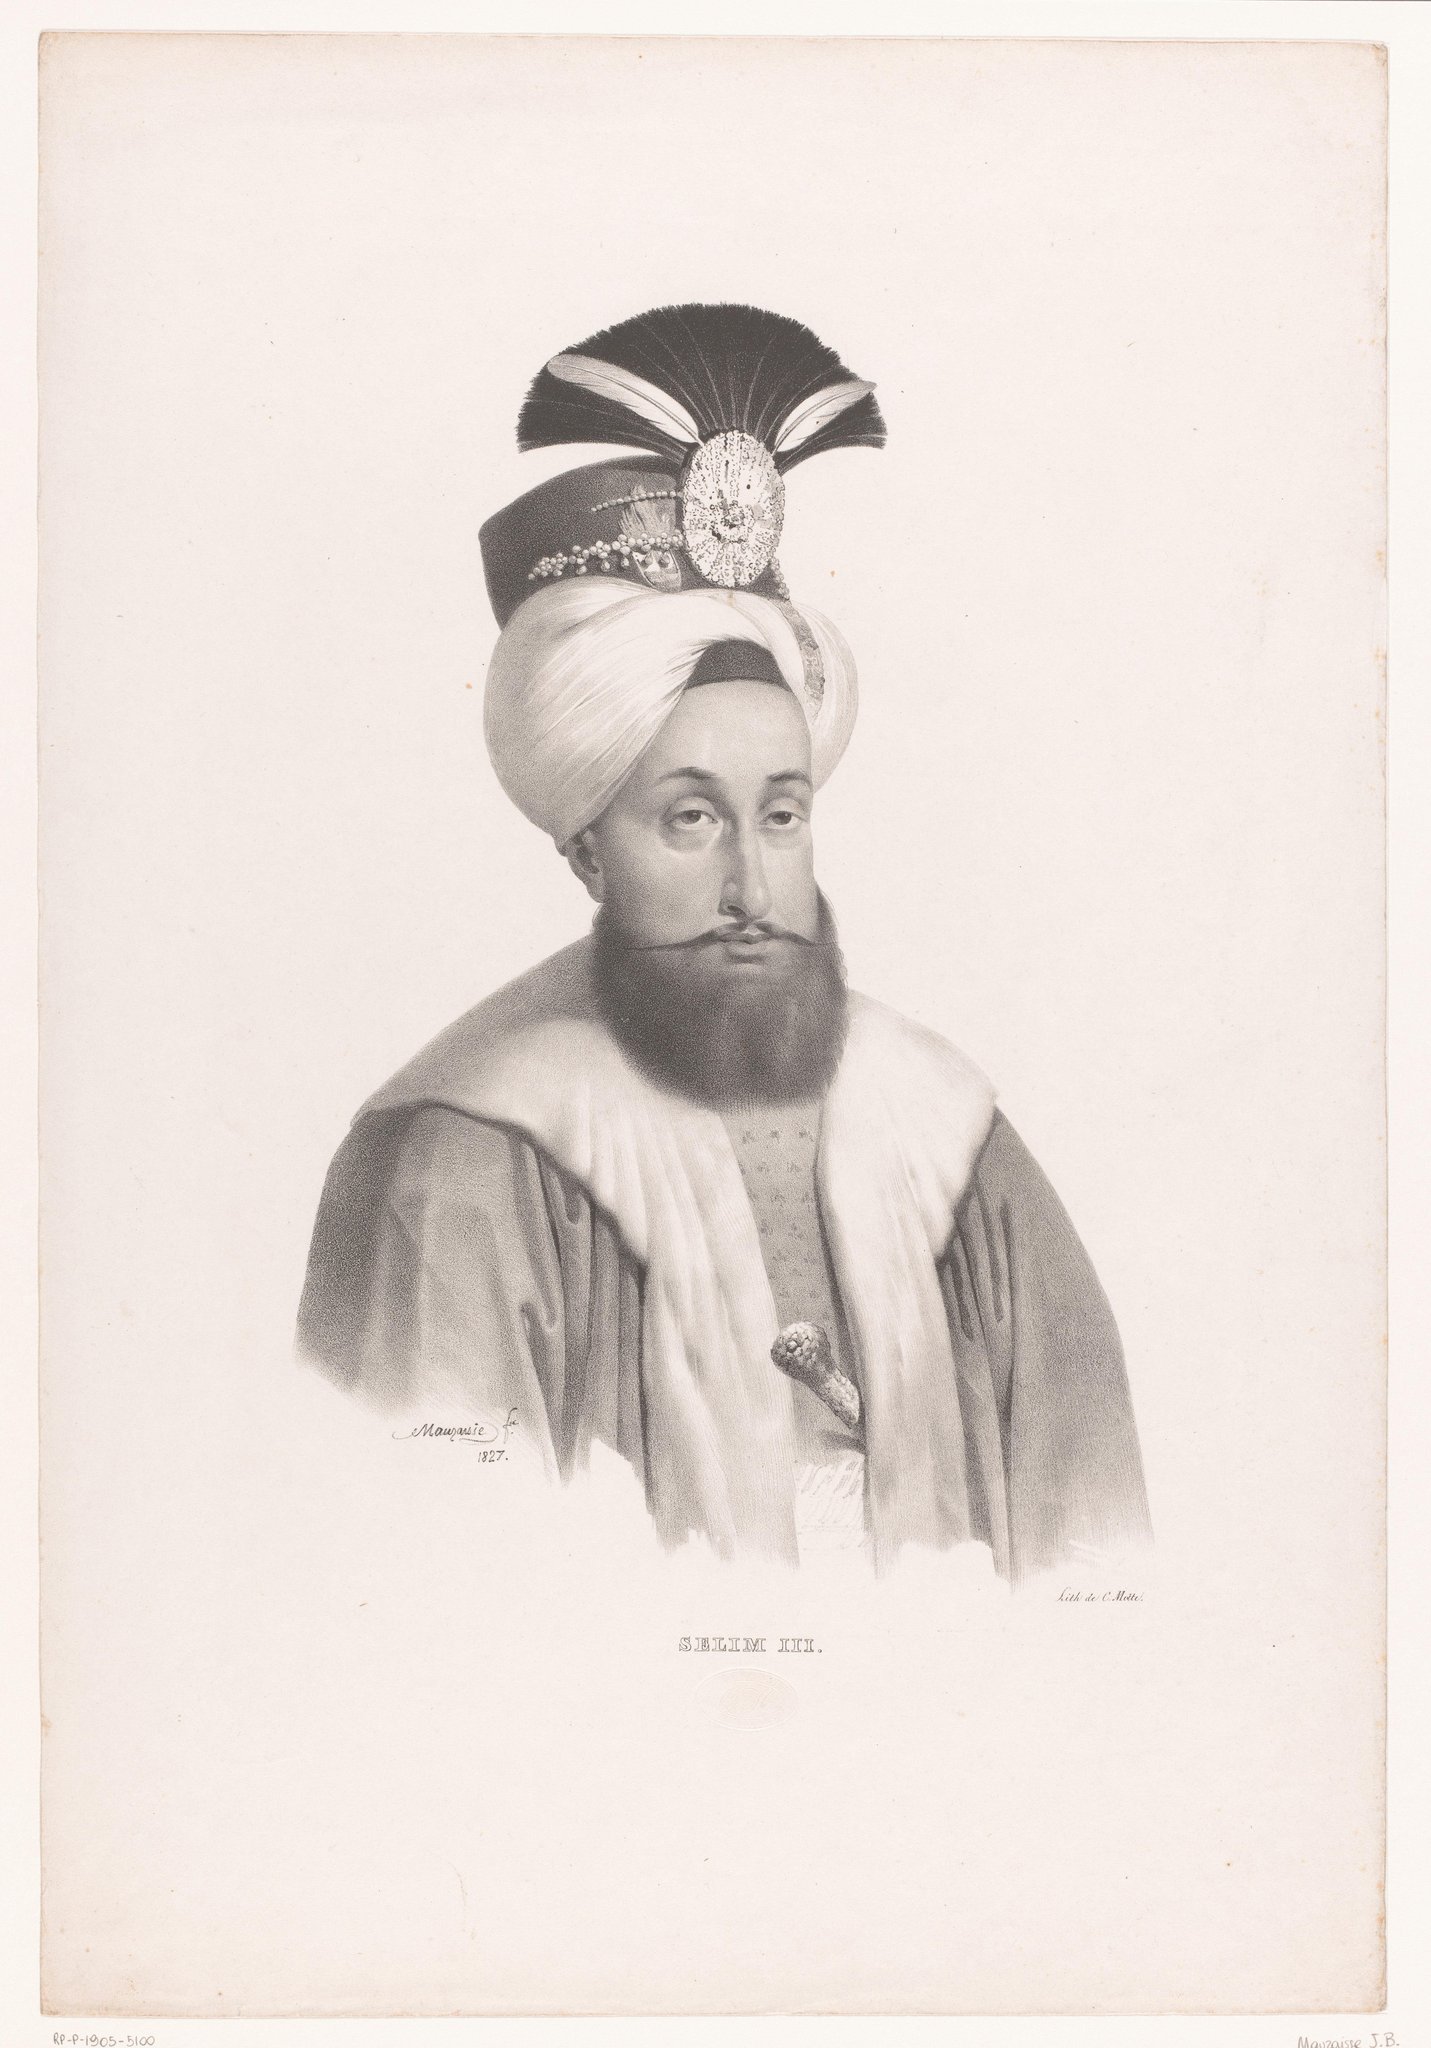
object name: print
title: Portret van Selim III, sultan van het Ottomaanse Rijk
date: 1827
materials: paper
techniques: lithograph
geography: paris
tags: historical persons, head-gear: turban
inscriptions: collector's mark: Lugt 2228, check stamp: Lugt 3996